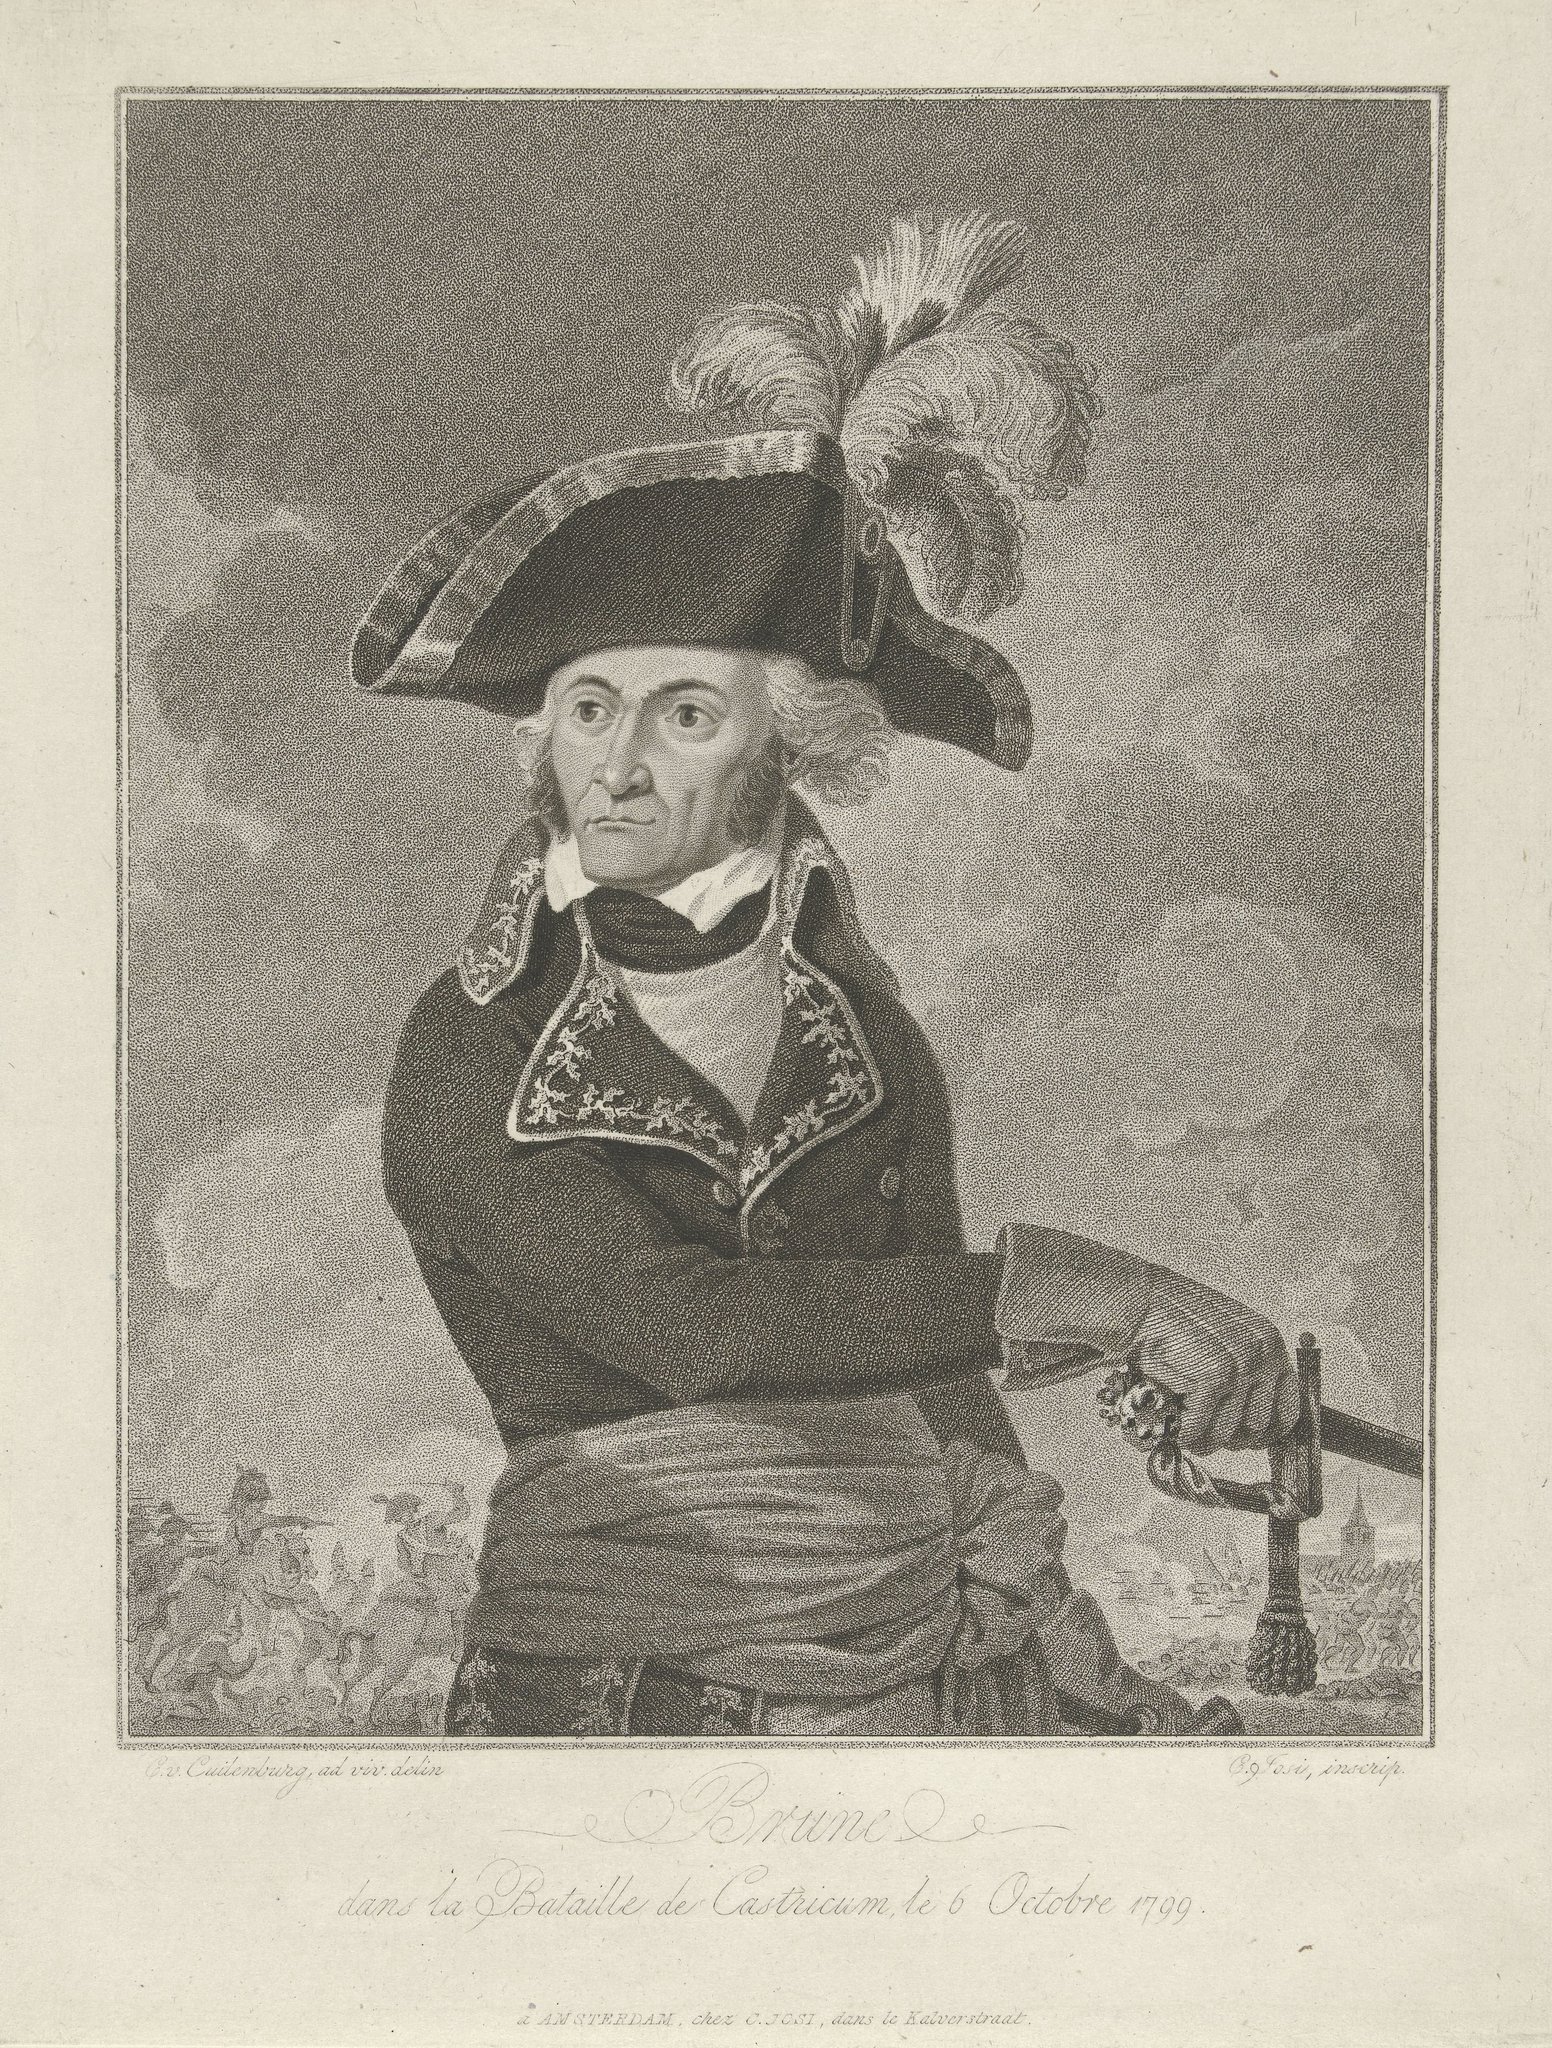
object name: print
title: Portret van Guillaume-Marie-Anne Brune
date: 1799-1818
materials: paper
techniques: engraving, etching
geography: amsterdam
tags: hacking and thrusting weapons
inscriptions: collector's mark: Lugt 2228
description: Portret van Guillaume-Marie-Anne Brune, in militair kostuum. In zijn rechterhand houdt hij een zwaard. Op de achtergrond de veldslag te Castricum. In de marge de naam van de geportretteerde en een onderschrift in het Frans.